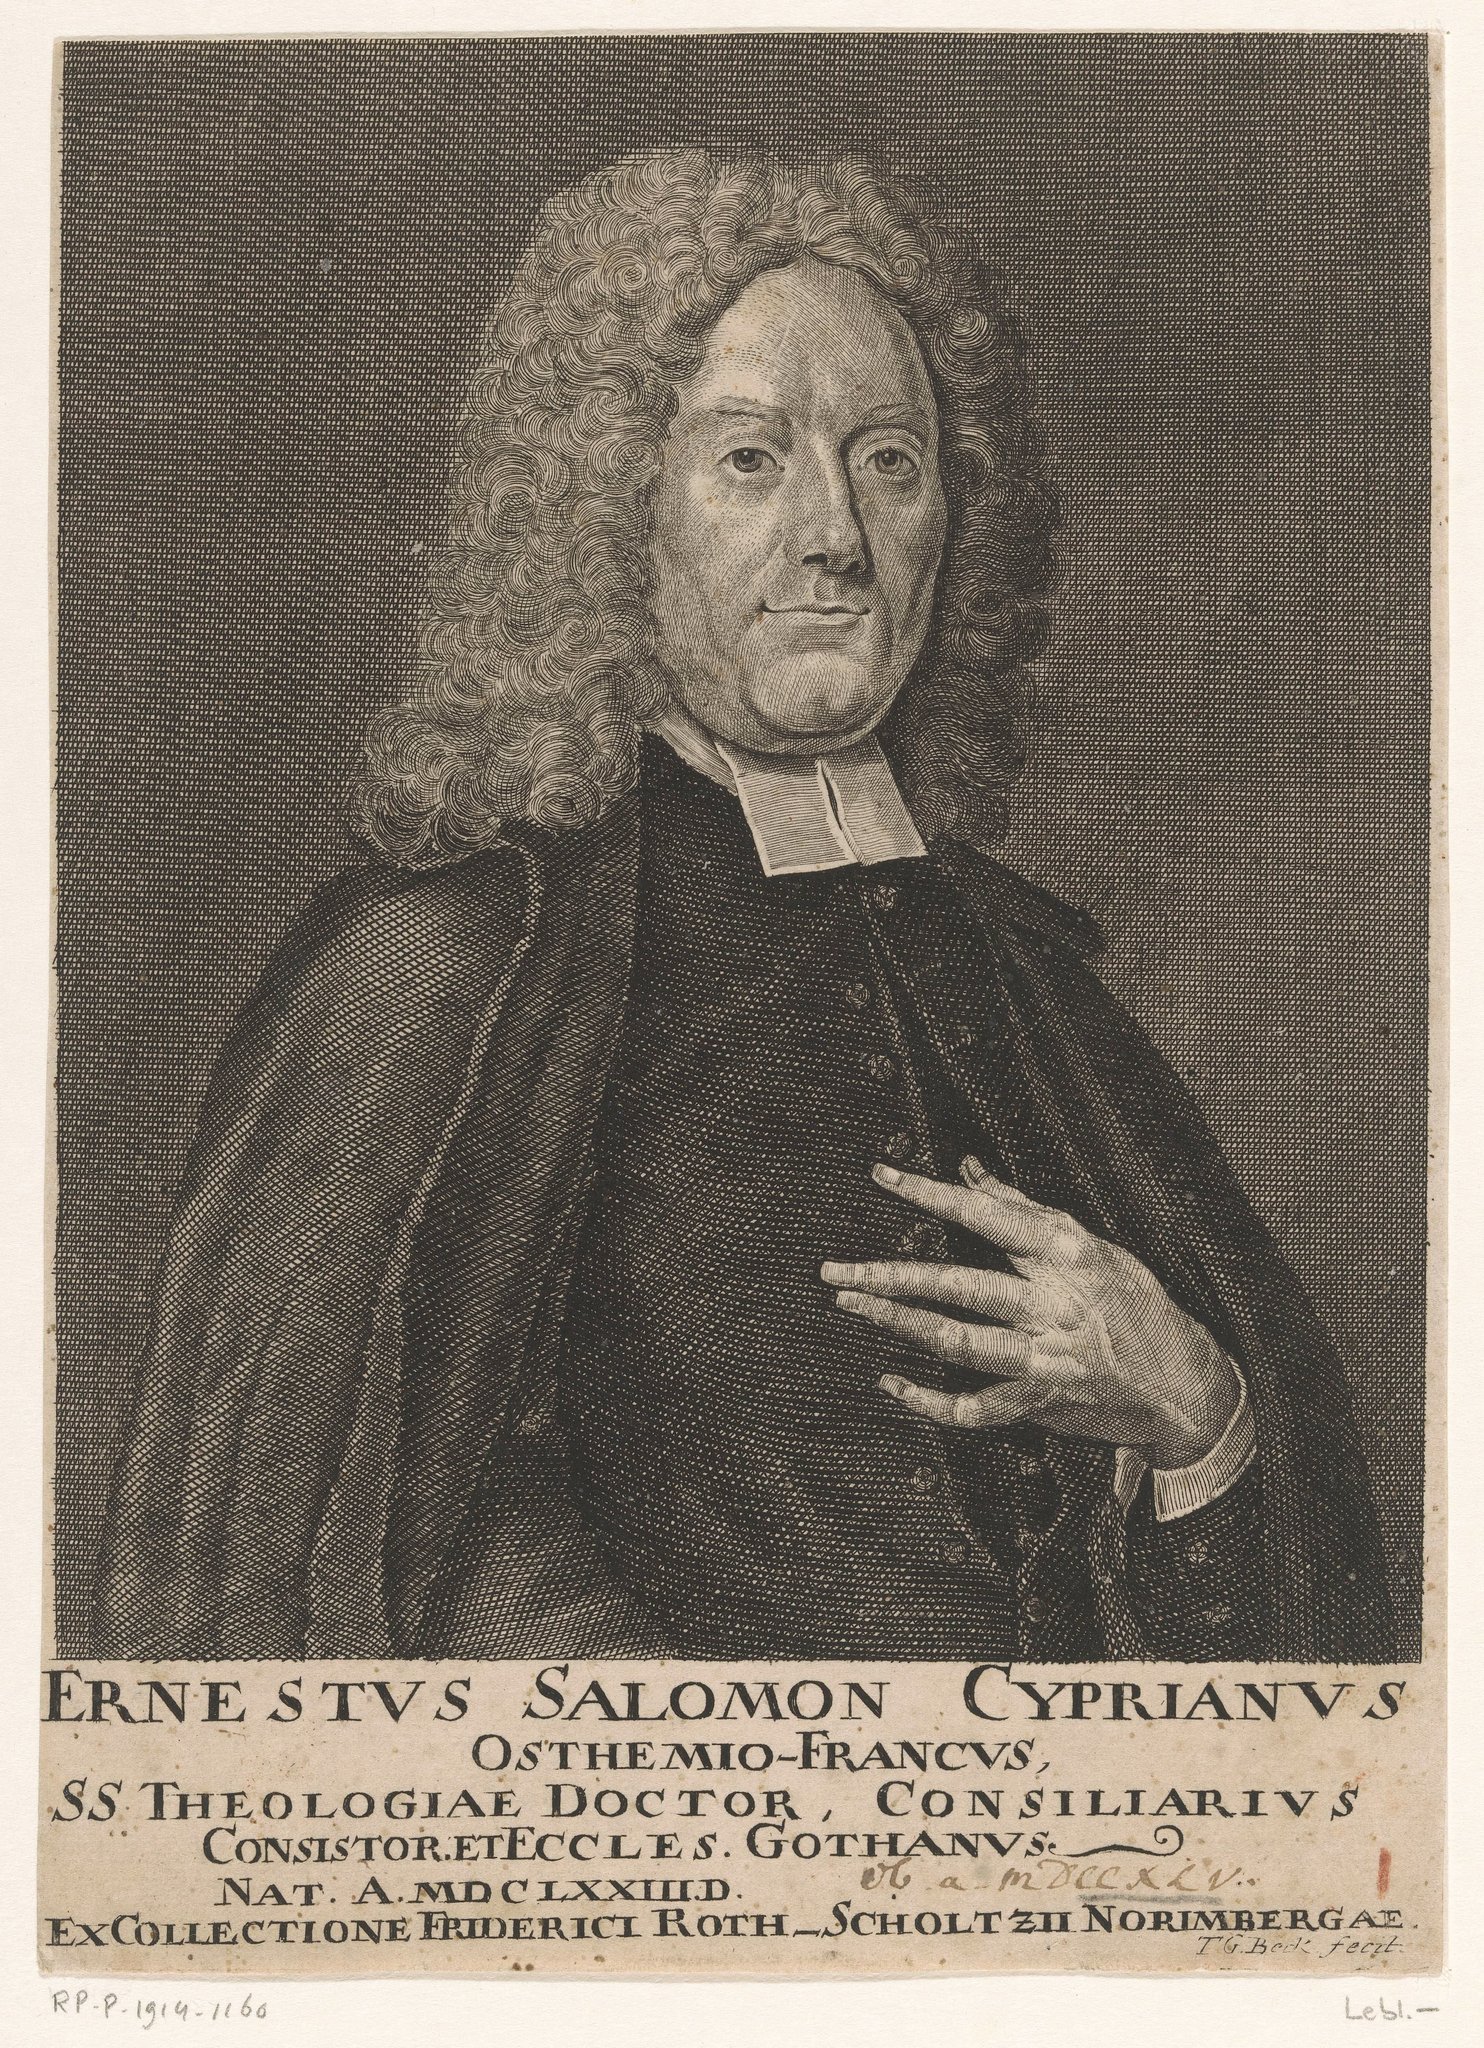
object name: print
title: Portret van Ernst Salomon Cyprianus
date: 1695-1755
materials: paper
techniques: engraving, etching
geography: nuremberg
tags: ernst salomon cyprianus, historical persons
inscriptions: collector's mark: Lugt 2228